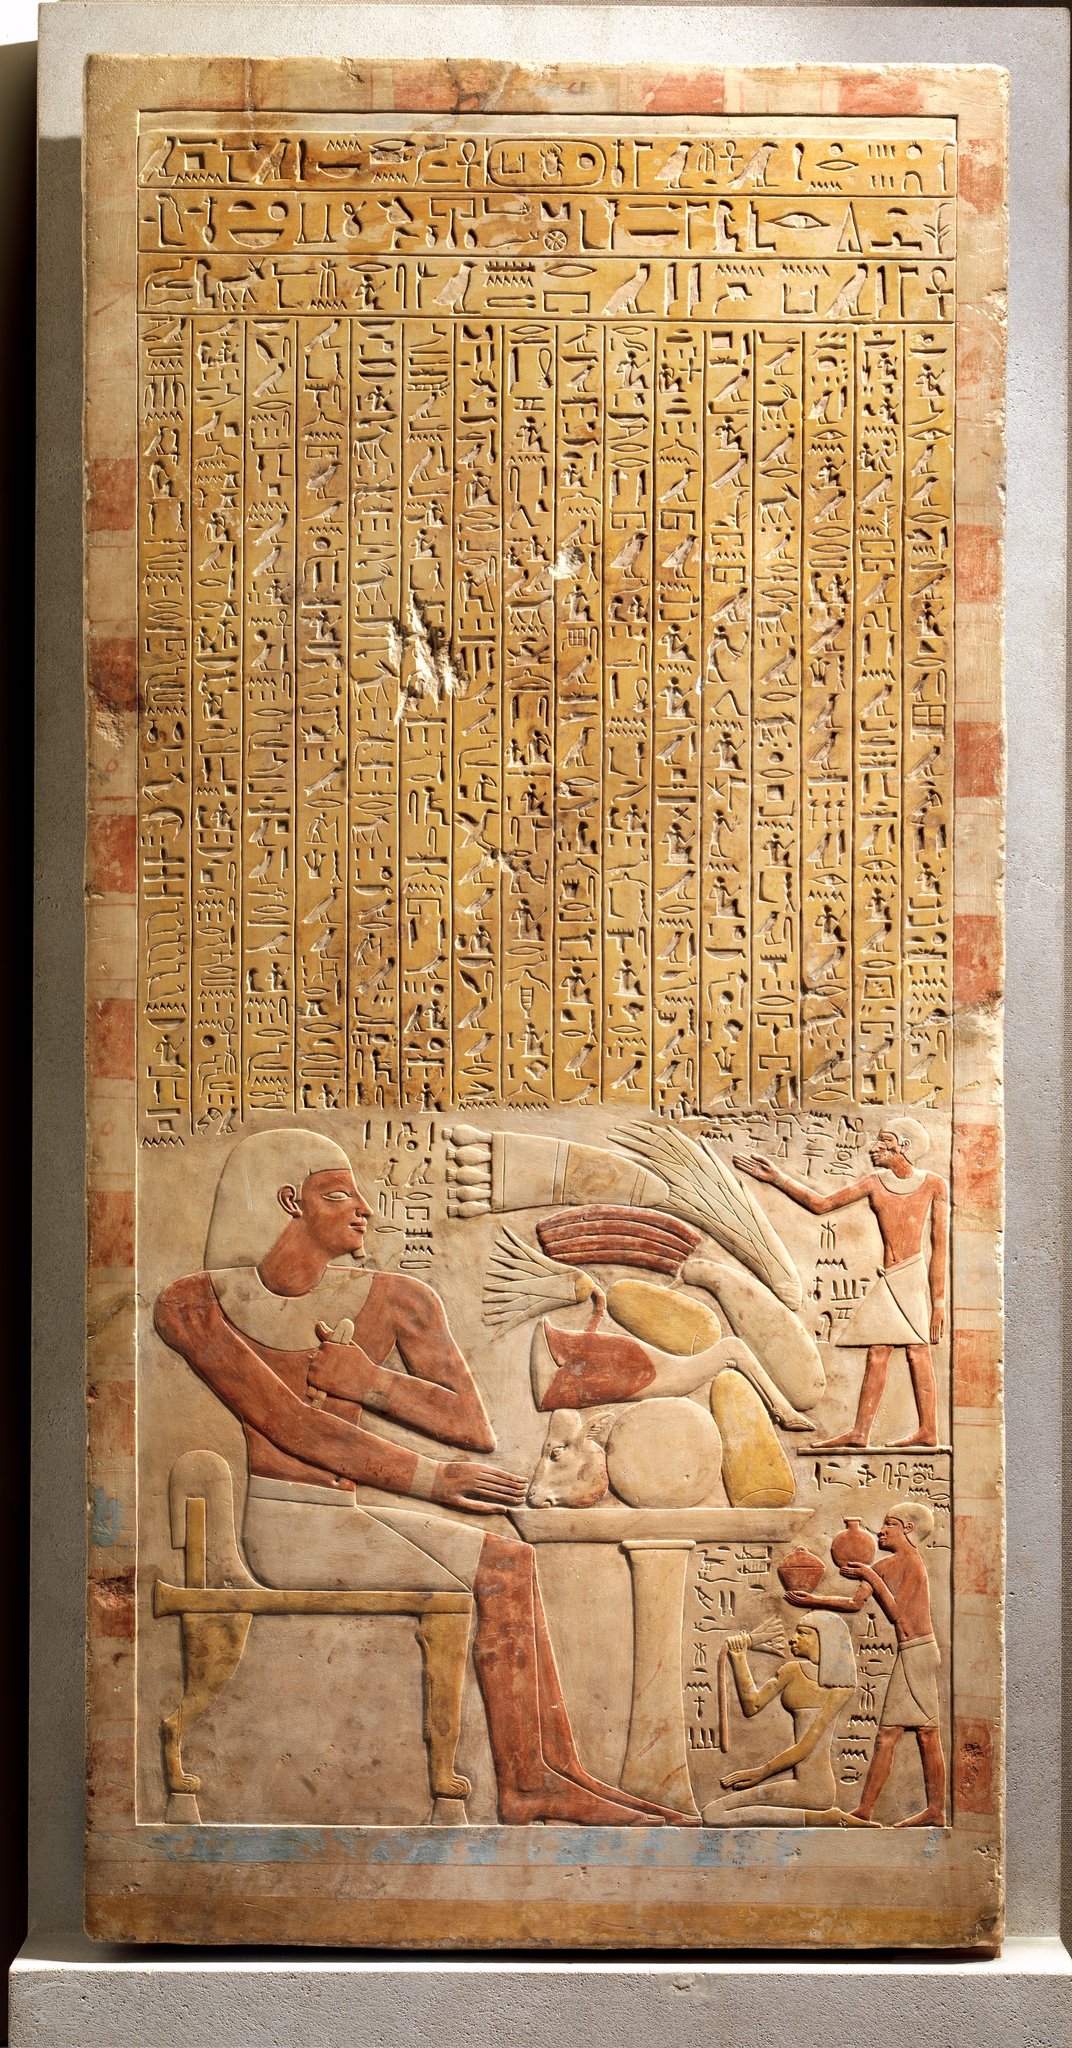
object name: stela, mentuwoser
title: Stela of the Steward Mentuwoser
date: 1944 BCE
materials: limestone, paint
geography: northern upper egypt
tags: food,men,hieroglyphs